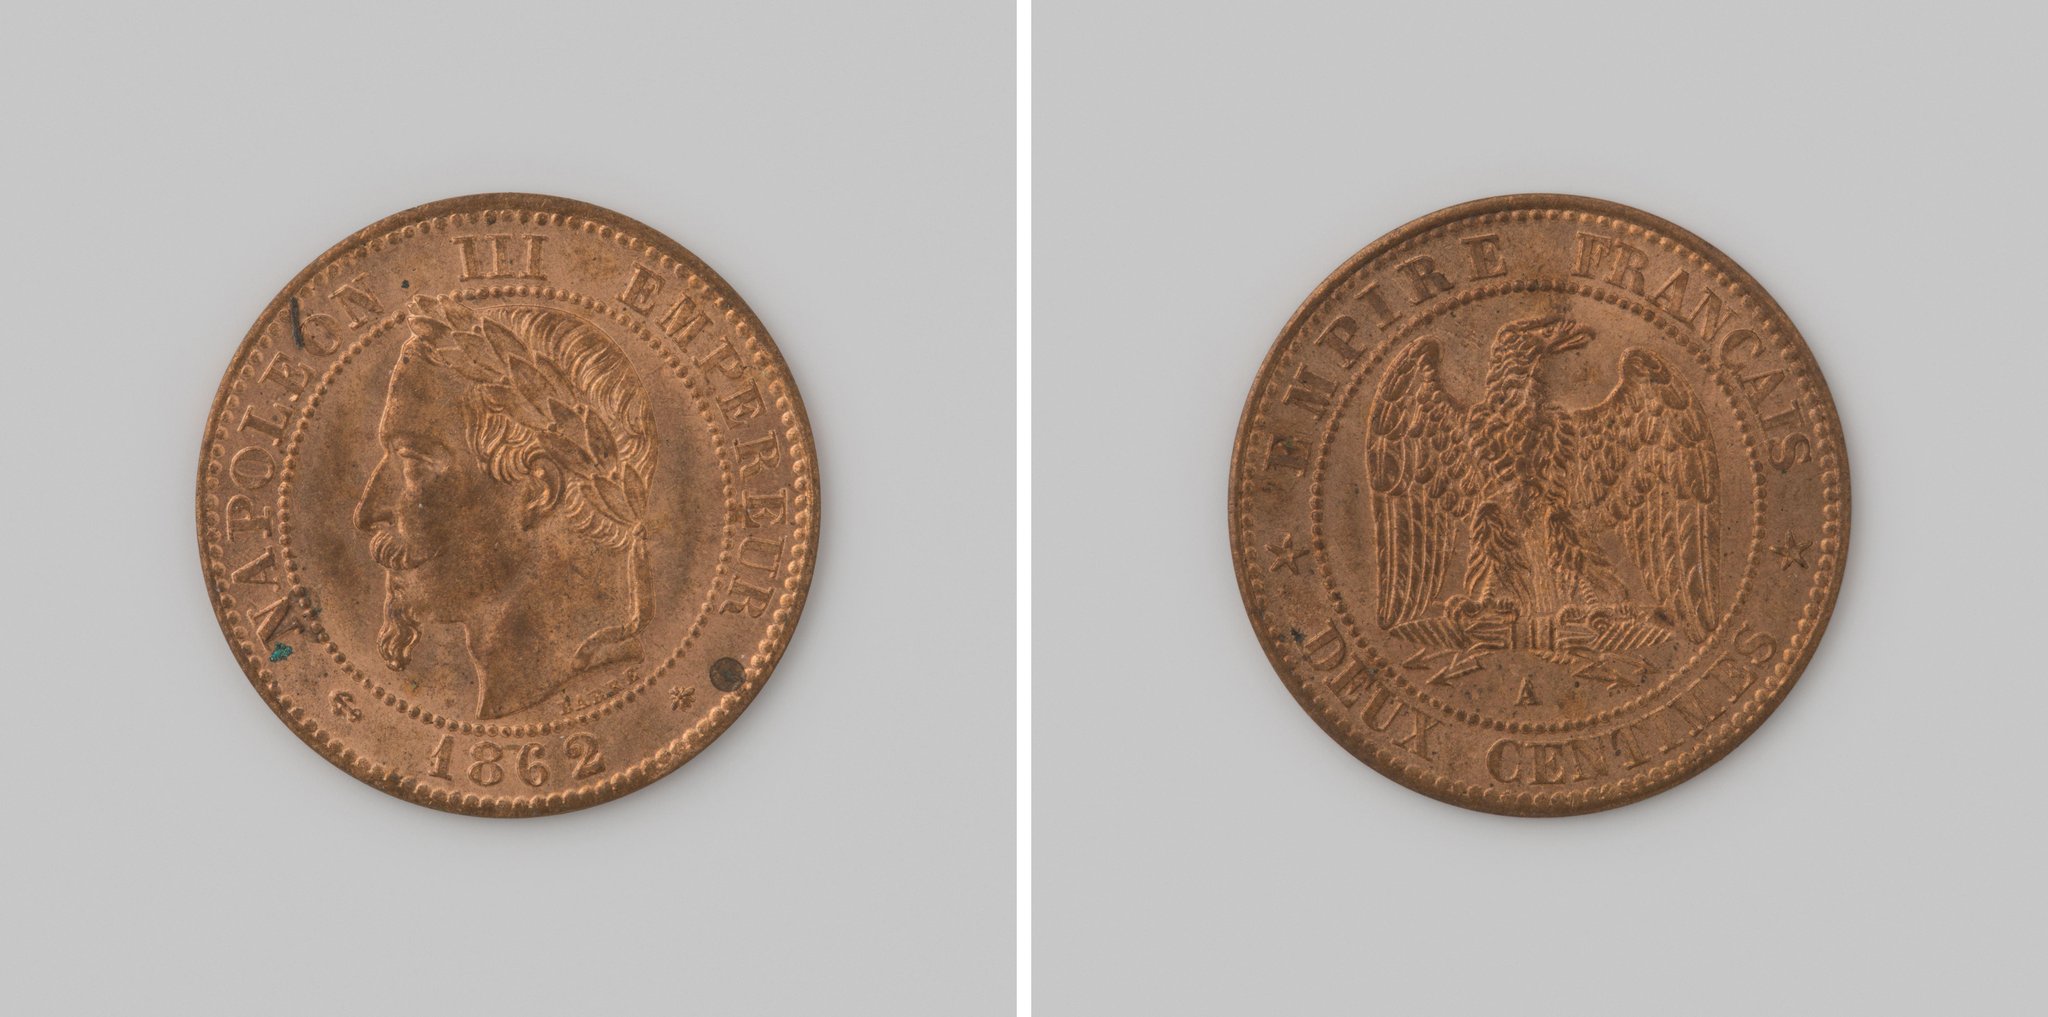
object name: coin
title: 2 centimes uit het keizerrijk Frankrijk van Napoleon III, 1862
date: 1862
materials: bronze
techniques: striking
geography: paris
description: Bronzen munt. Voorzijde: gelauwerd hoofd van de keizer naar links. Jaartal onderaan. Keerzijde: op bundel, waaruit bliksemschichten, staande, naar rechts kijkende adelaar met gespreide vleugels, waaronder de letter A [=Parijs]. Waarde-aanduiding onderaan in omschrift. Gladde rand.